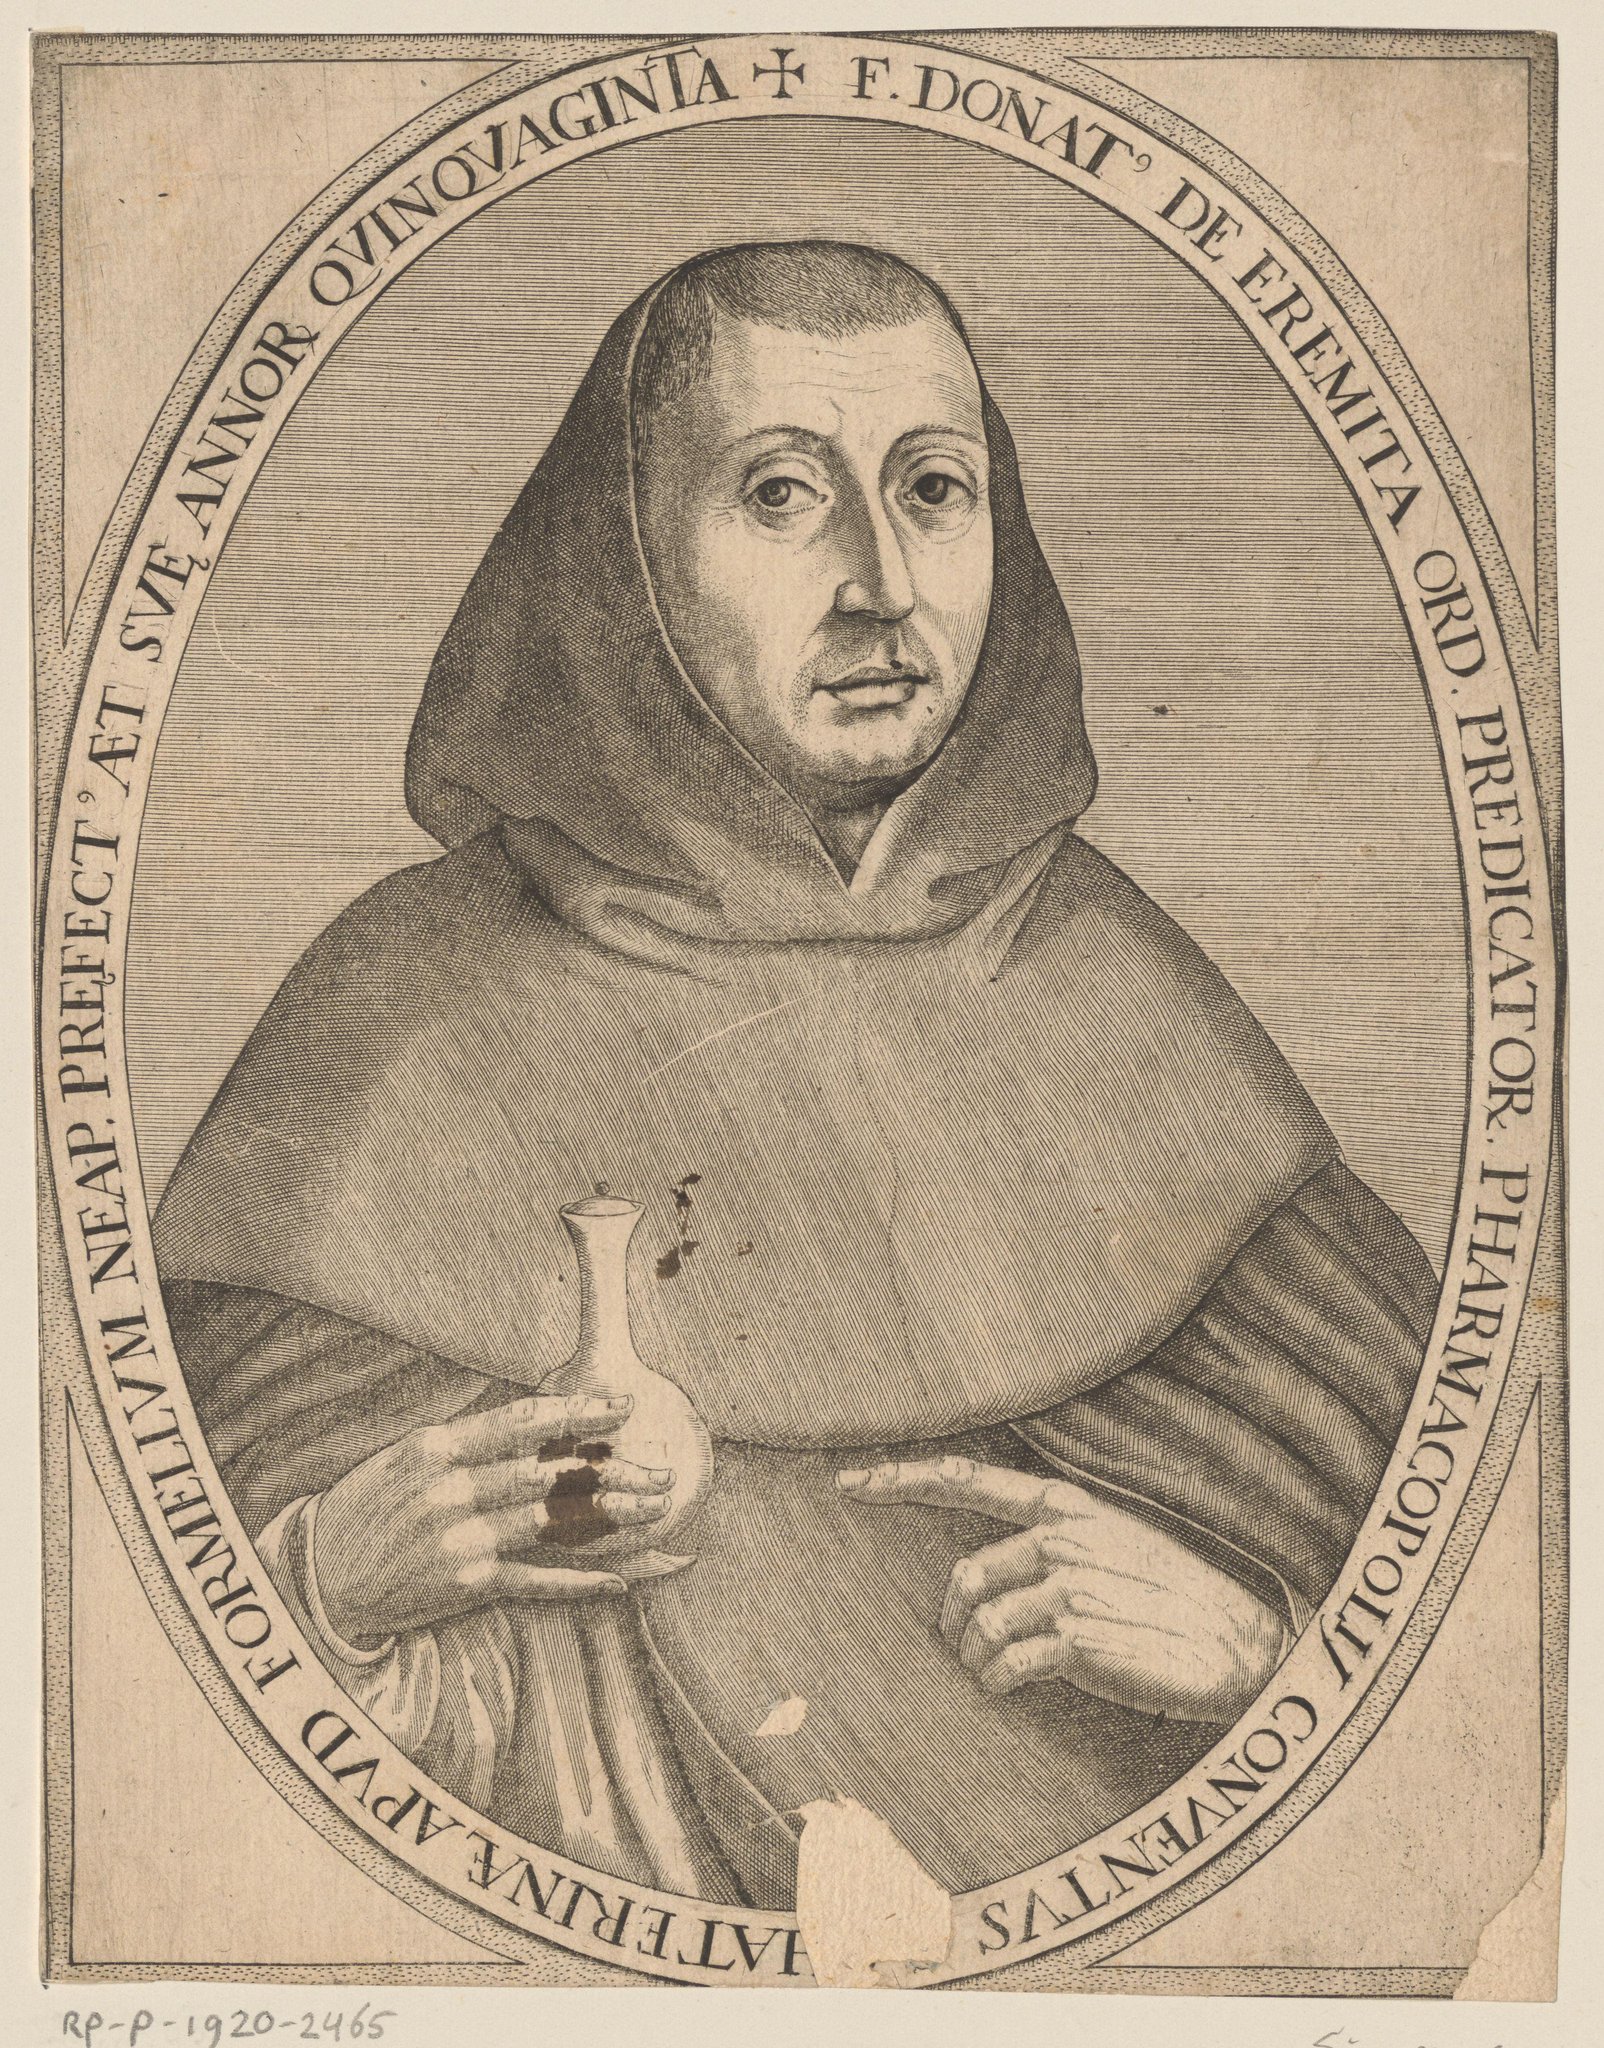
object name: print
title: Portret van Donat de Eremita op 50-jarige leeftijd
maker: Anonymous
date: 1600-1670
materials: paper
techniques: engraving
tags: historical persons, monk(s), friar(s)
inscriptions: collector's mark: Lugt 2228